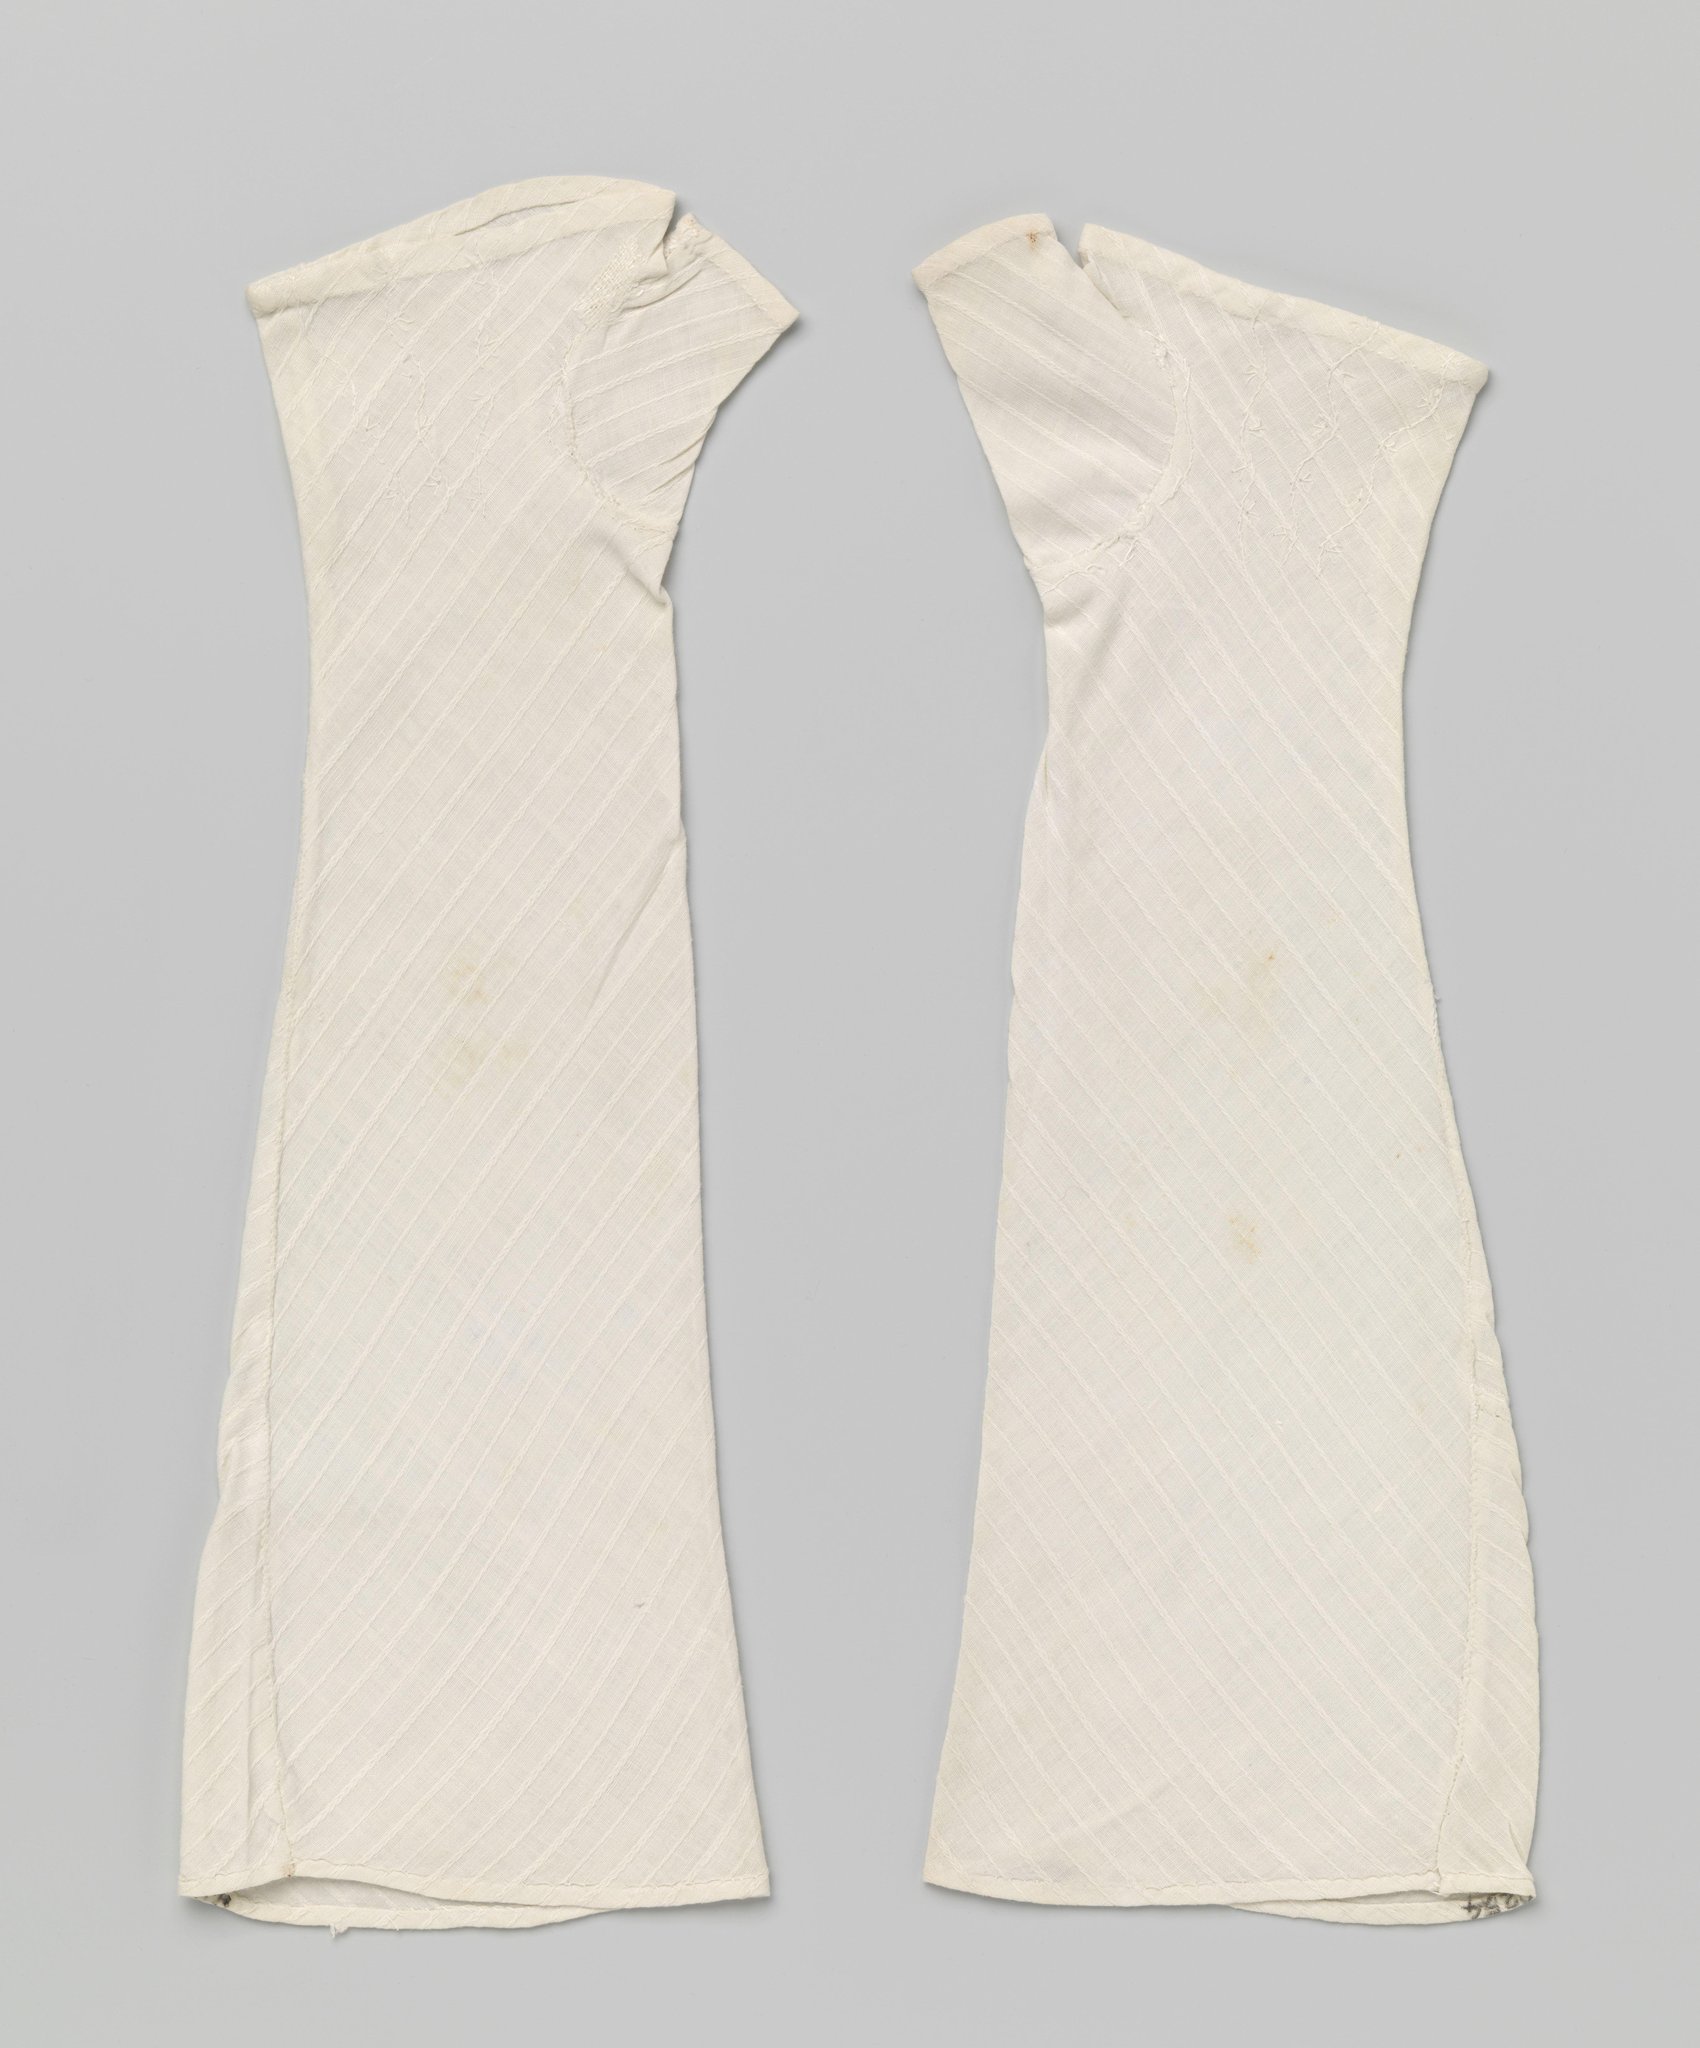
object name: glove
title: Mitaine van witte gestreepte katoen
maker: Anonymous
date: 1880-1900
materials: cotton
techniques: embroidered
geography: western europe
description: Linkermitaine van witte gestreepte katoen. Op de rug drie geborduurde slingerlijnen.